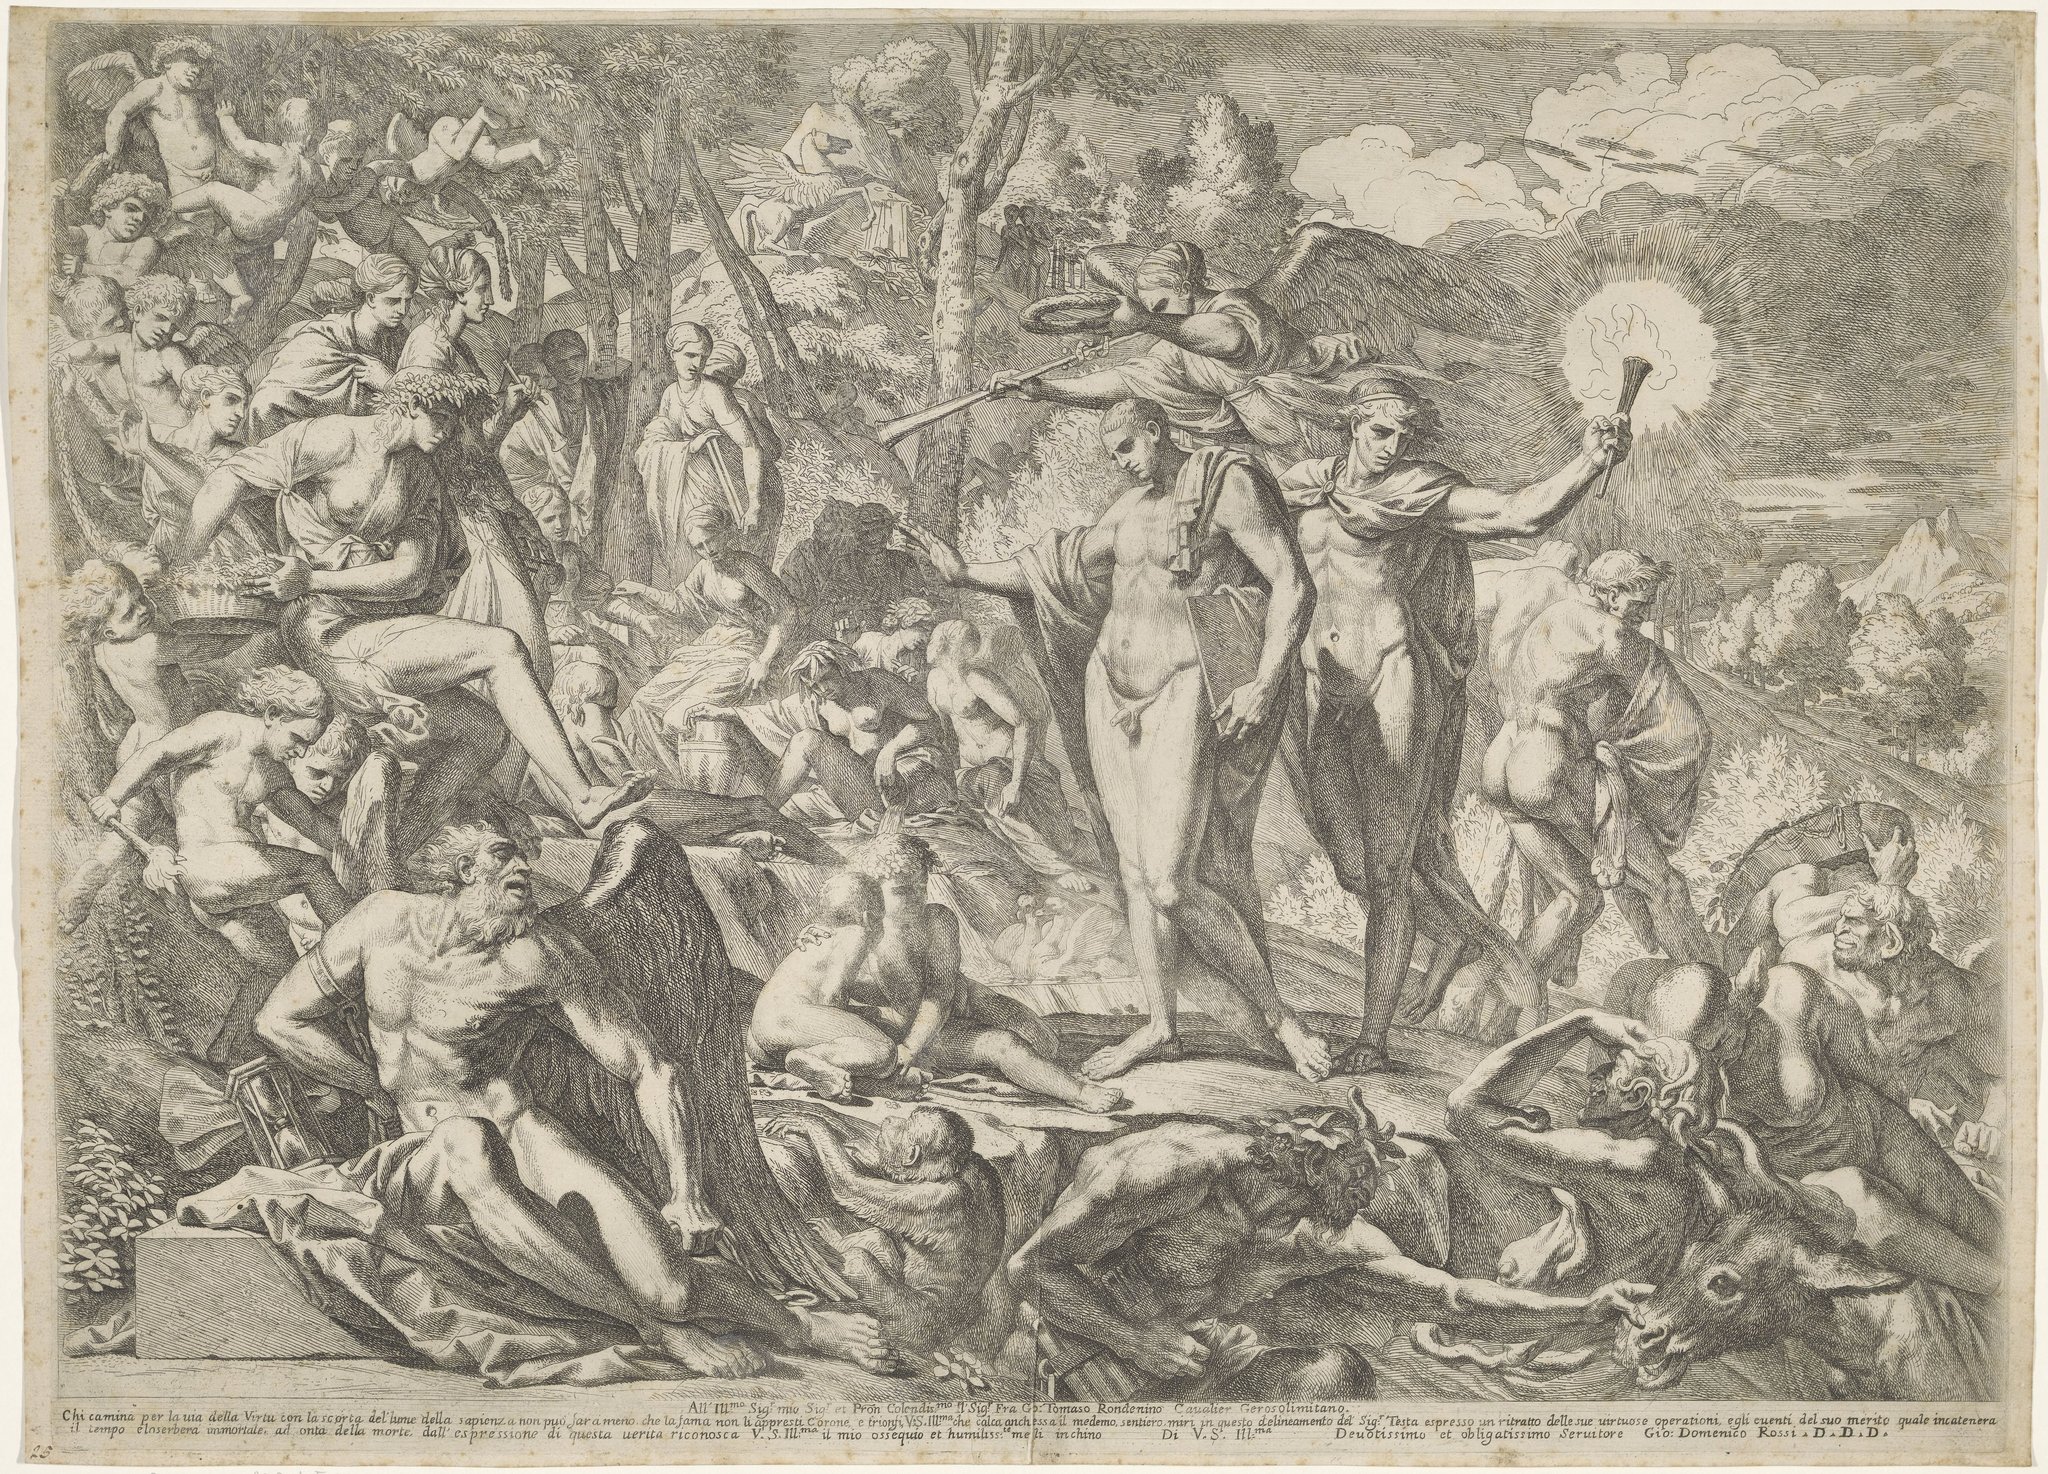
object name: print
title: Jongeman arriveert op de Parnassus langs de weg van de Deugd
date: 1621-1650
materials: paper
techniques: etching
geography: italy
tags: parnassus, sacred to apollo musagetes, good behaviour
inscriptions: collector's mark: Lugt 11, collector's mark: ‘Hinloopen’, number: ‘25’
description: Allegorische voorstelling met een jongeman die op de Parnassus aankomt na over de weg van de Deugd te hebben gelopen. Op de Parnassus verschillende mythologische figuren en dieren. Opdracht in het Italiaans in ondermarge.